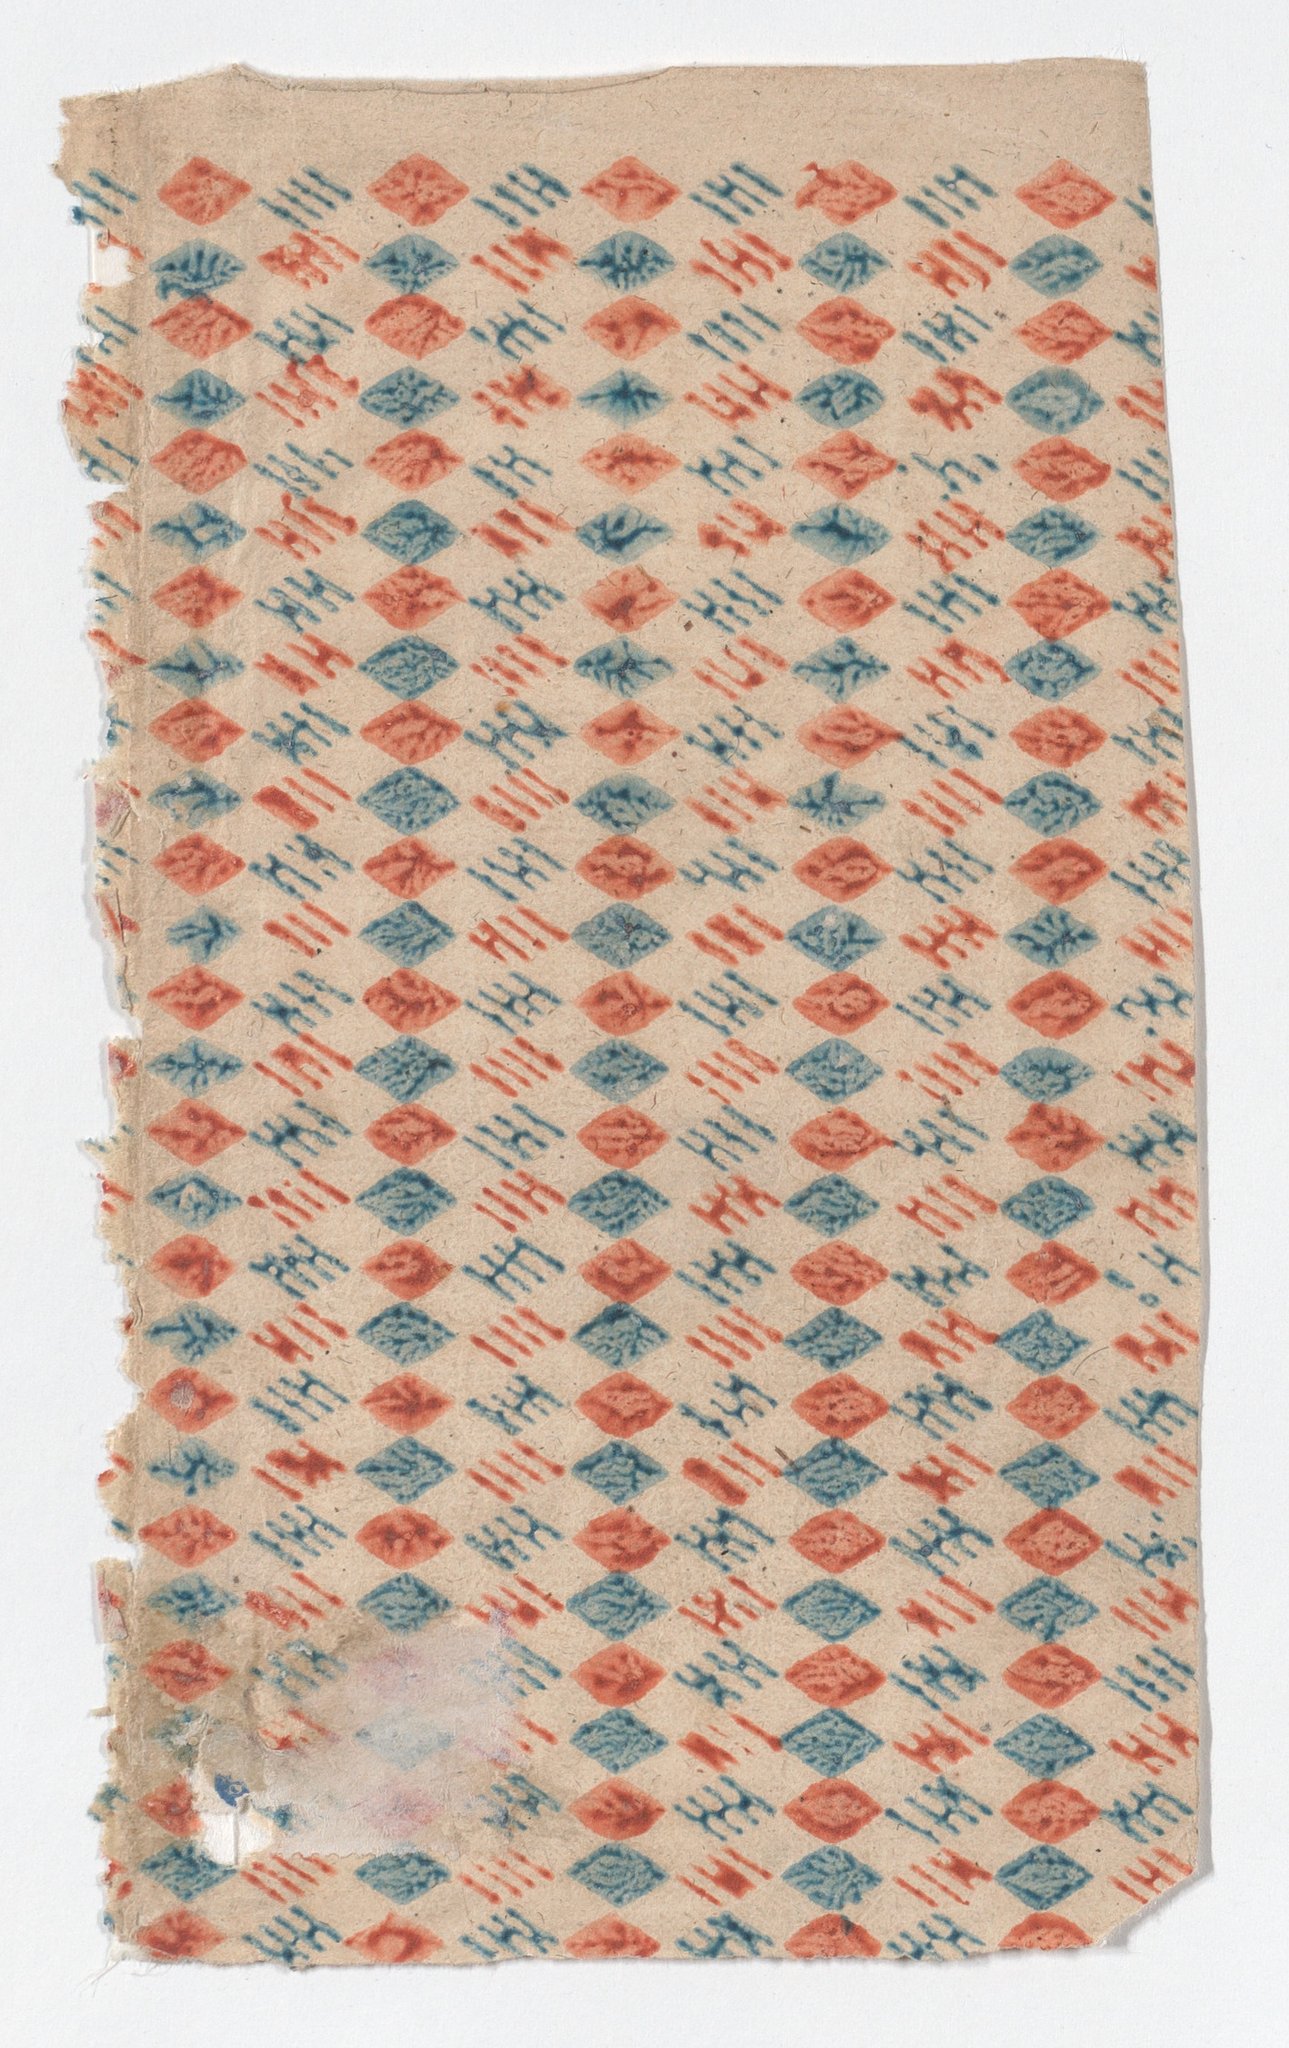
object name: print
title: Sheet with overall blue and red diamond pattern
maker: Anonymous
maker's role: artist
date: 1801-1900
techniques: relief print